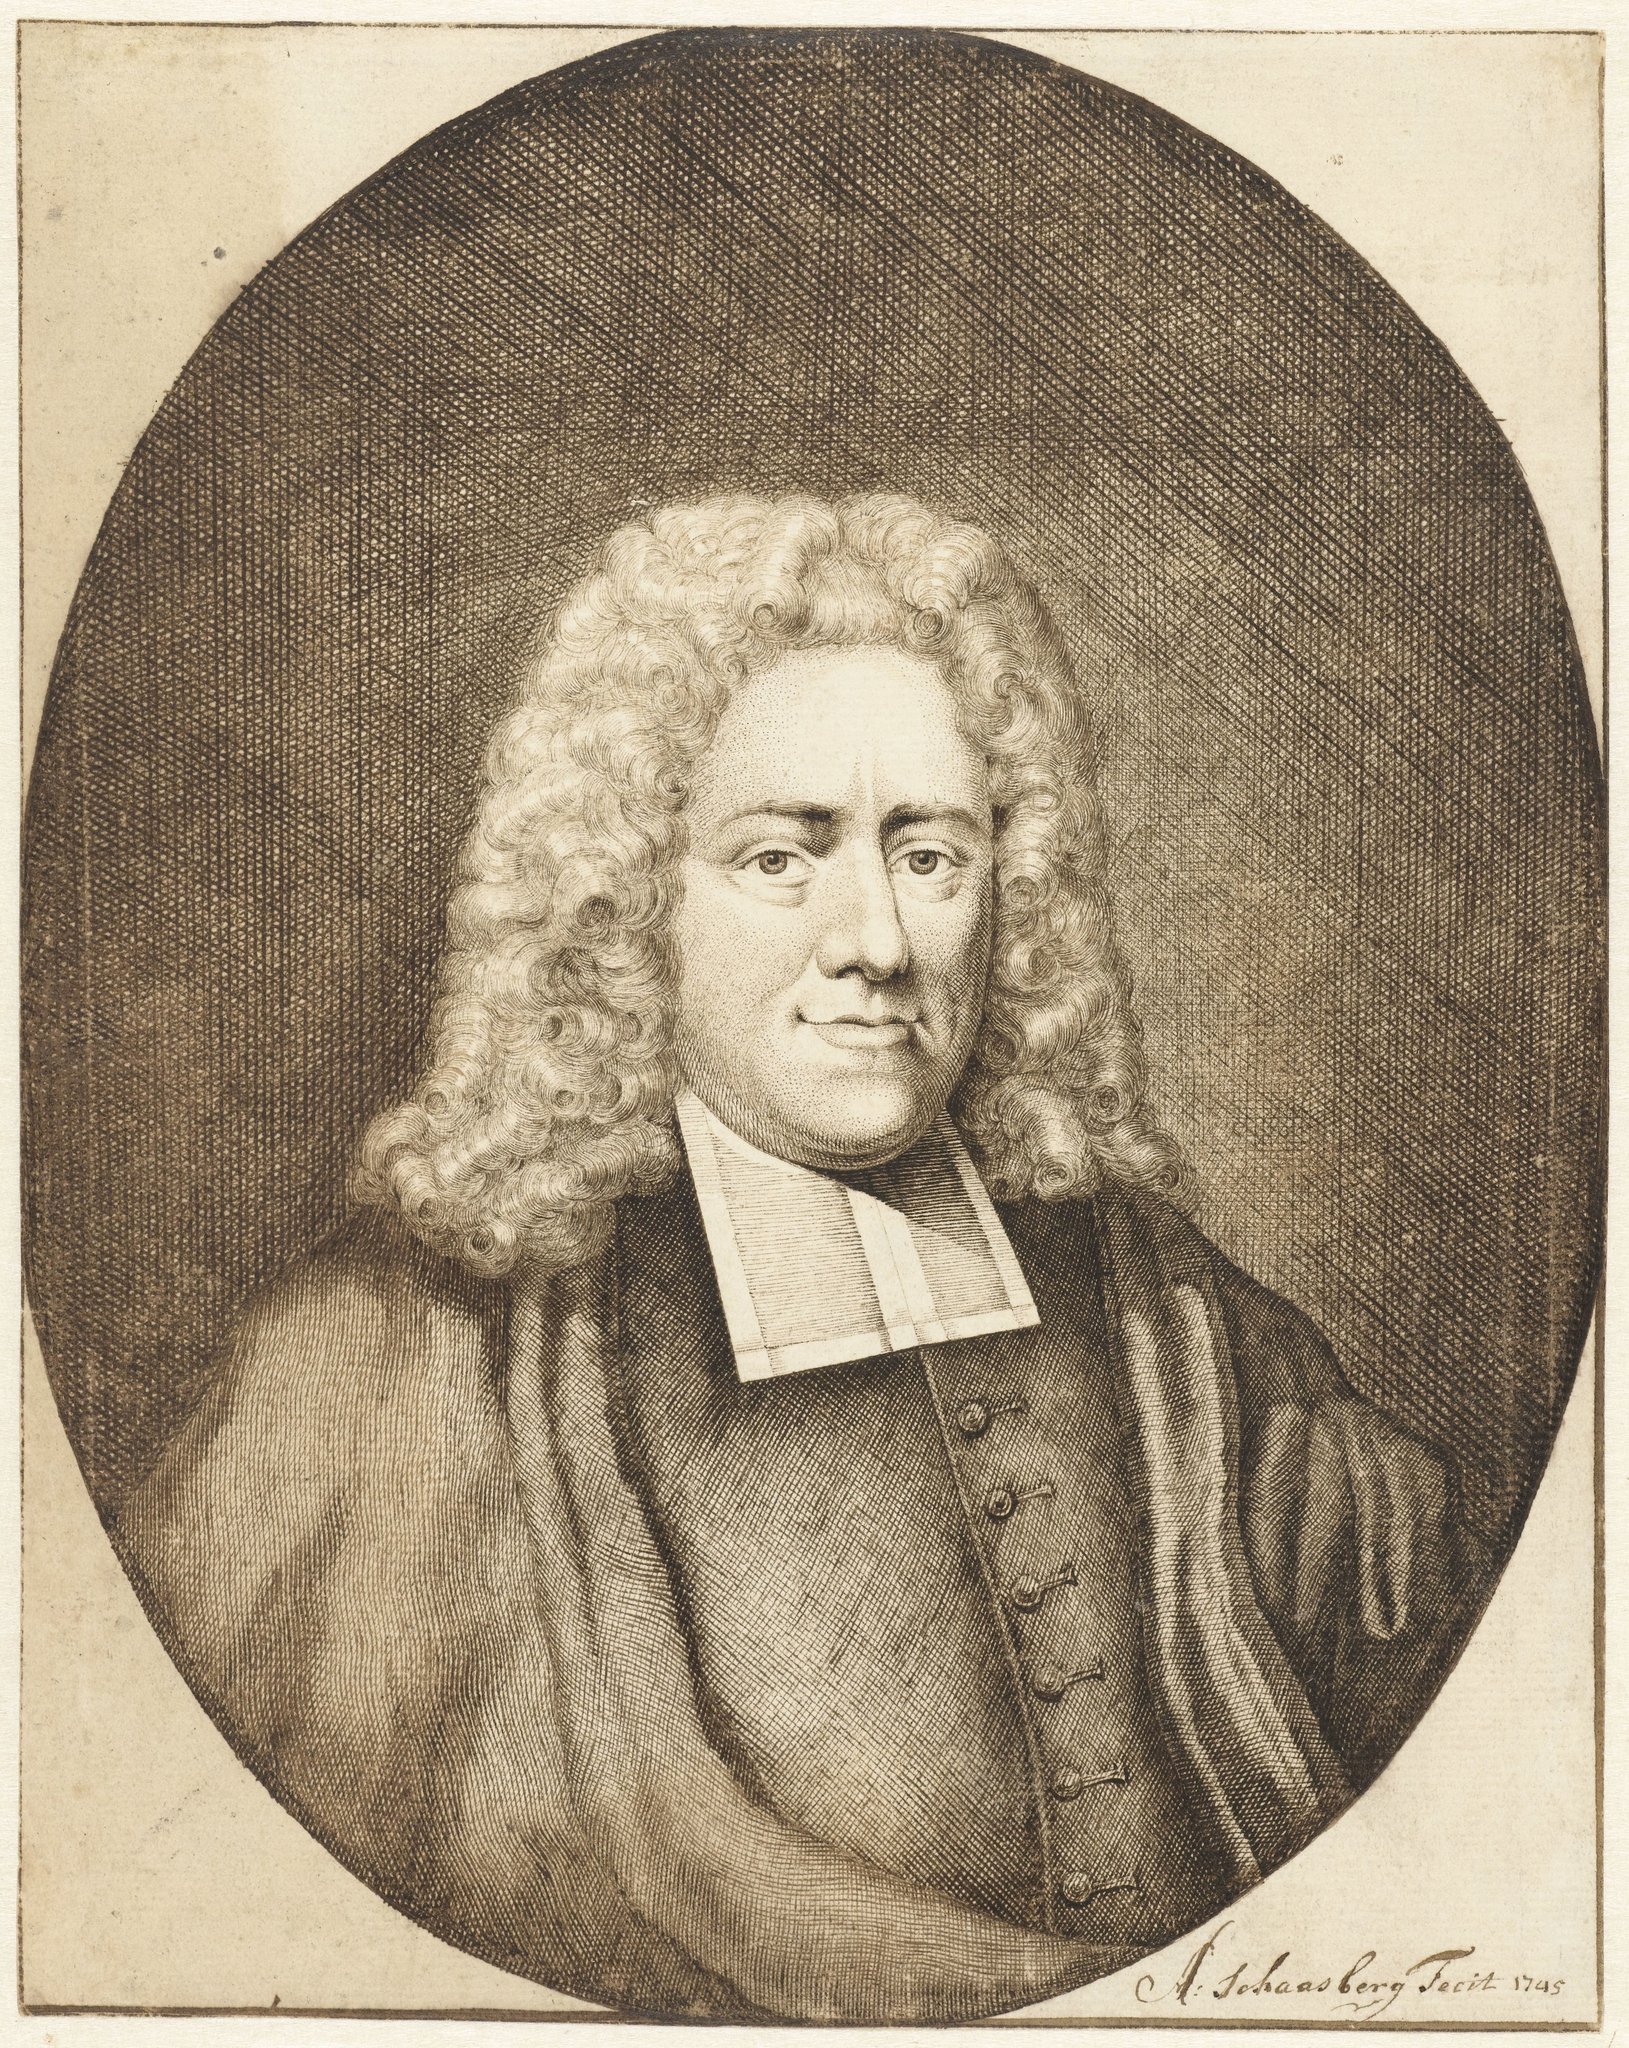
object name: drawing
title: Portret van Ds. Ludovicus Timon Pielat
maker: adriaen schaasberg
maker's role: draughtsman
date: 1745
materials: ink, paper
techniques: pen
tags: rotterdam, historical persons